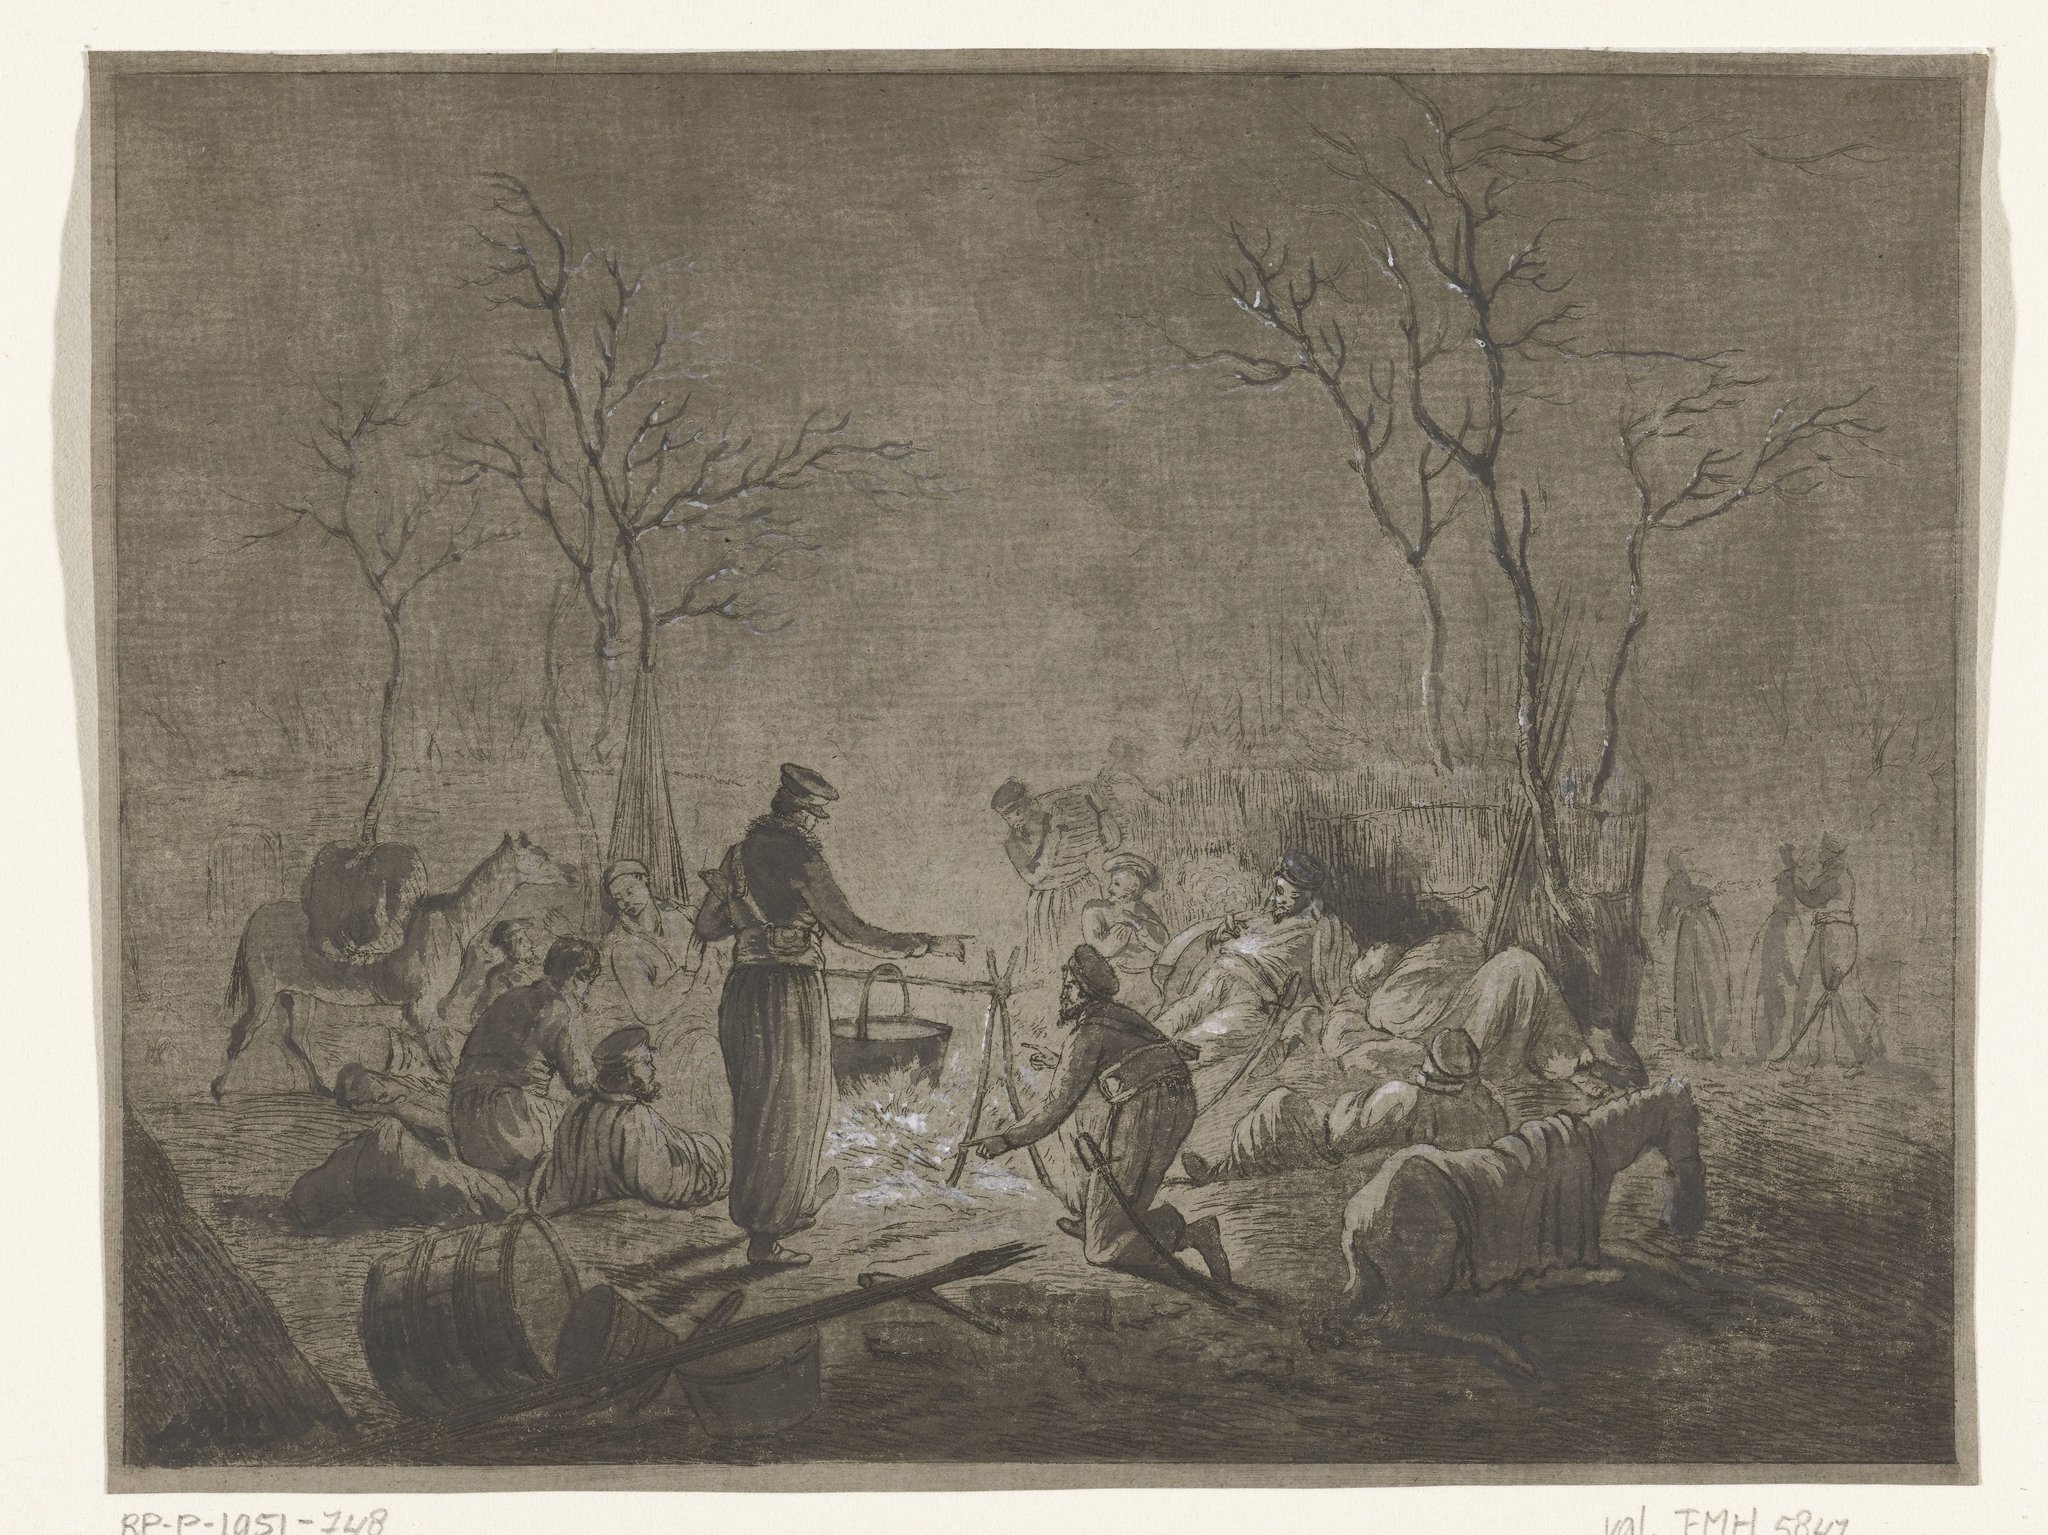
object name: print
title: Bivak van Kozakken bij vuur tijdens Franse bezetting in 1813 te Amsterdam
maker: pieter bartholomeusz. barbiers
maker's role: draughtsman, print maker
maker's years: 1772-1837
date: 1813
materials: paint, paper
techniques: brush, etching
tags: the soldier; the soldier's life, shelter ~ military service, amsterdam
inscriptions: collector's mark: Lugt 2228